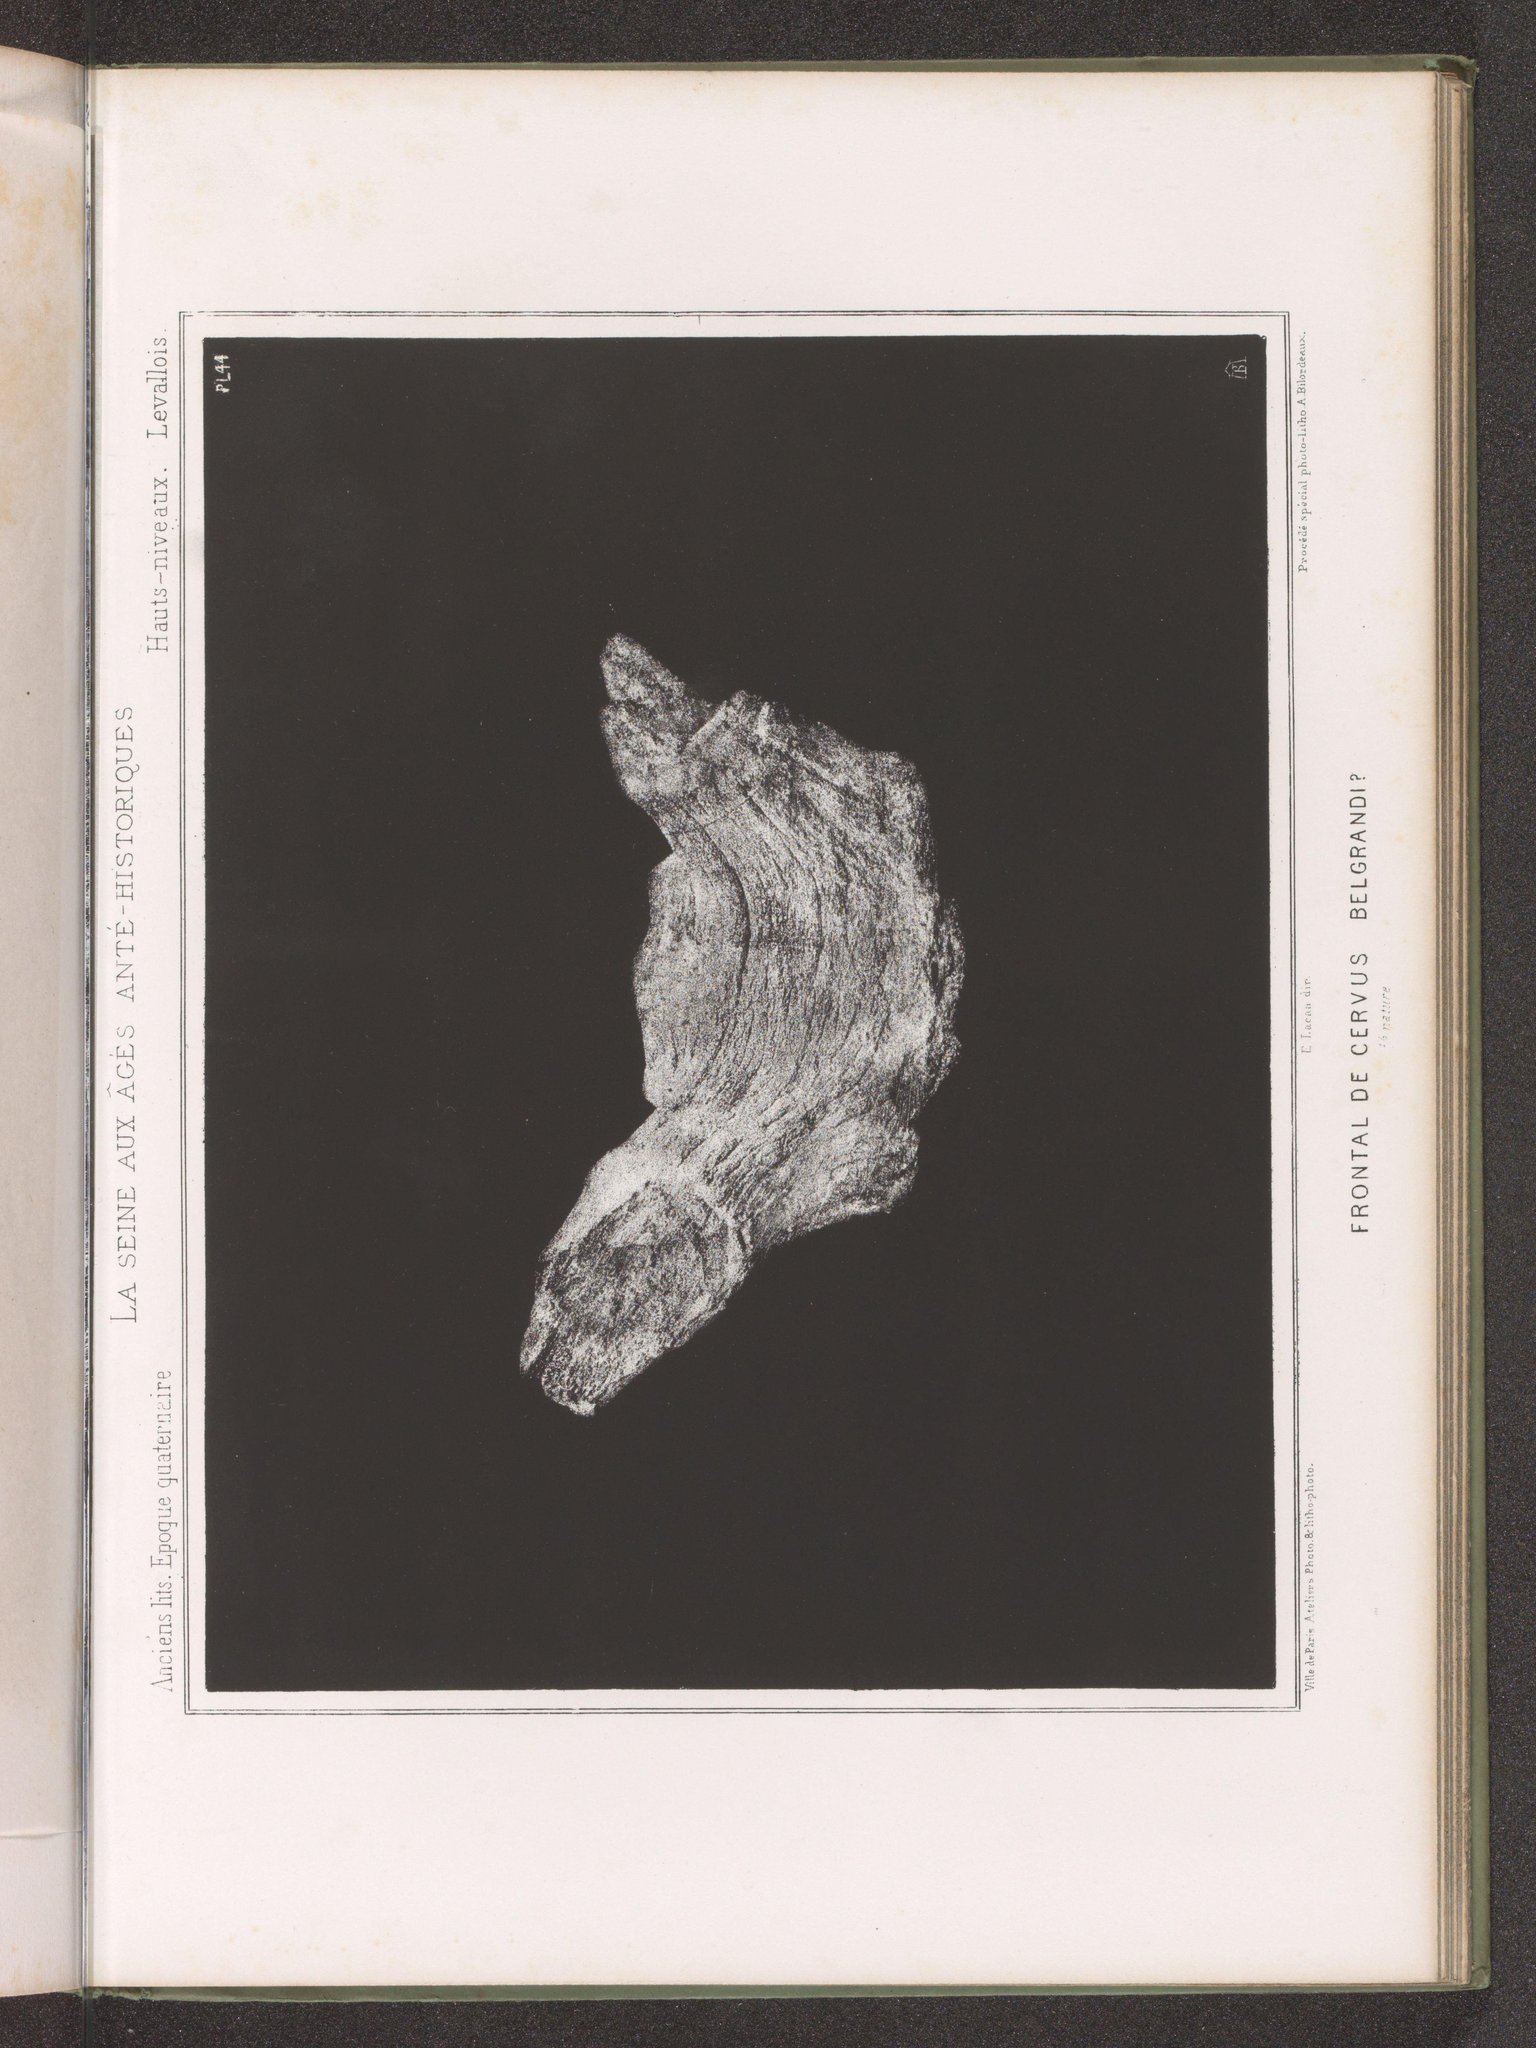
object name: photomechanical print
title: FRONTAL DE CERVUS BELGRANDI? 1/2 nature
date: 1860-1869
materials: paper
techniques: photolithography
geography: paris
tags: animals (+ skeleton of an animal), palaeontology, france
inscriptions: number: ‘Pl. 44’, monogram: ‘AB’, inscription: ‘Ville de Paris Ateliers photo & litho-photo. E. Lacan, dir. Procédé spécial photo-litho A. Bilordeaux’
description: Voor plek prent in boek: zie nummer onder 'Opschriften / Merken'.